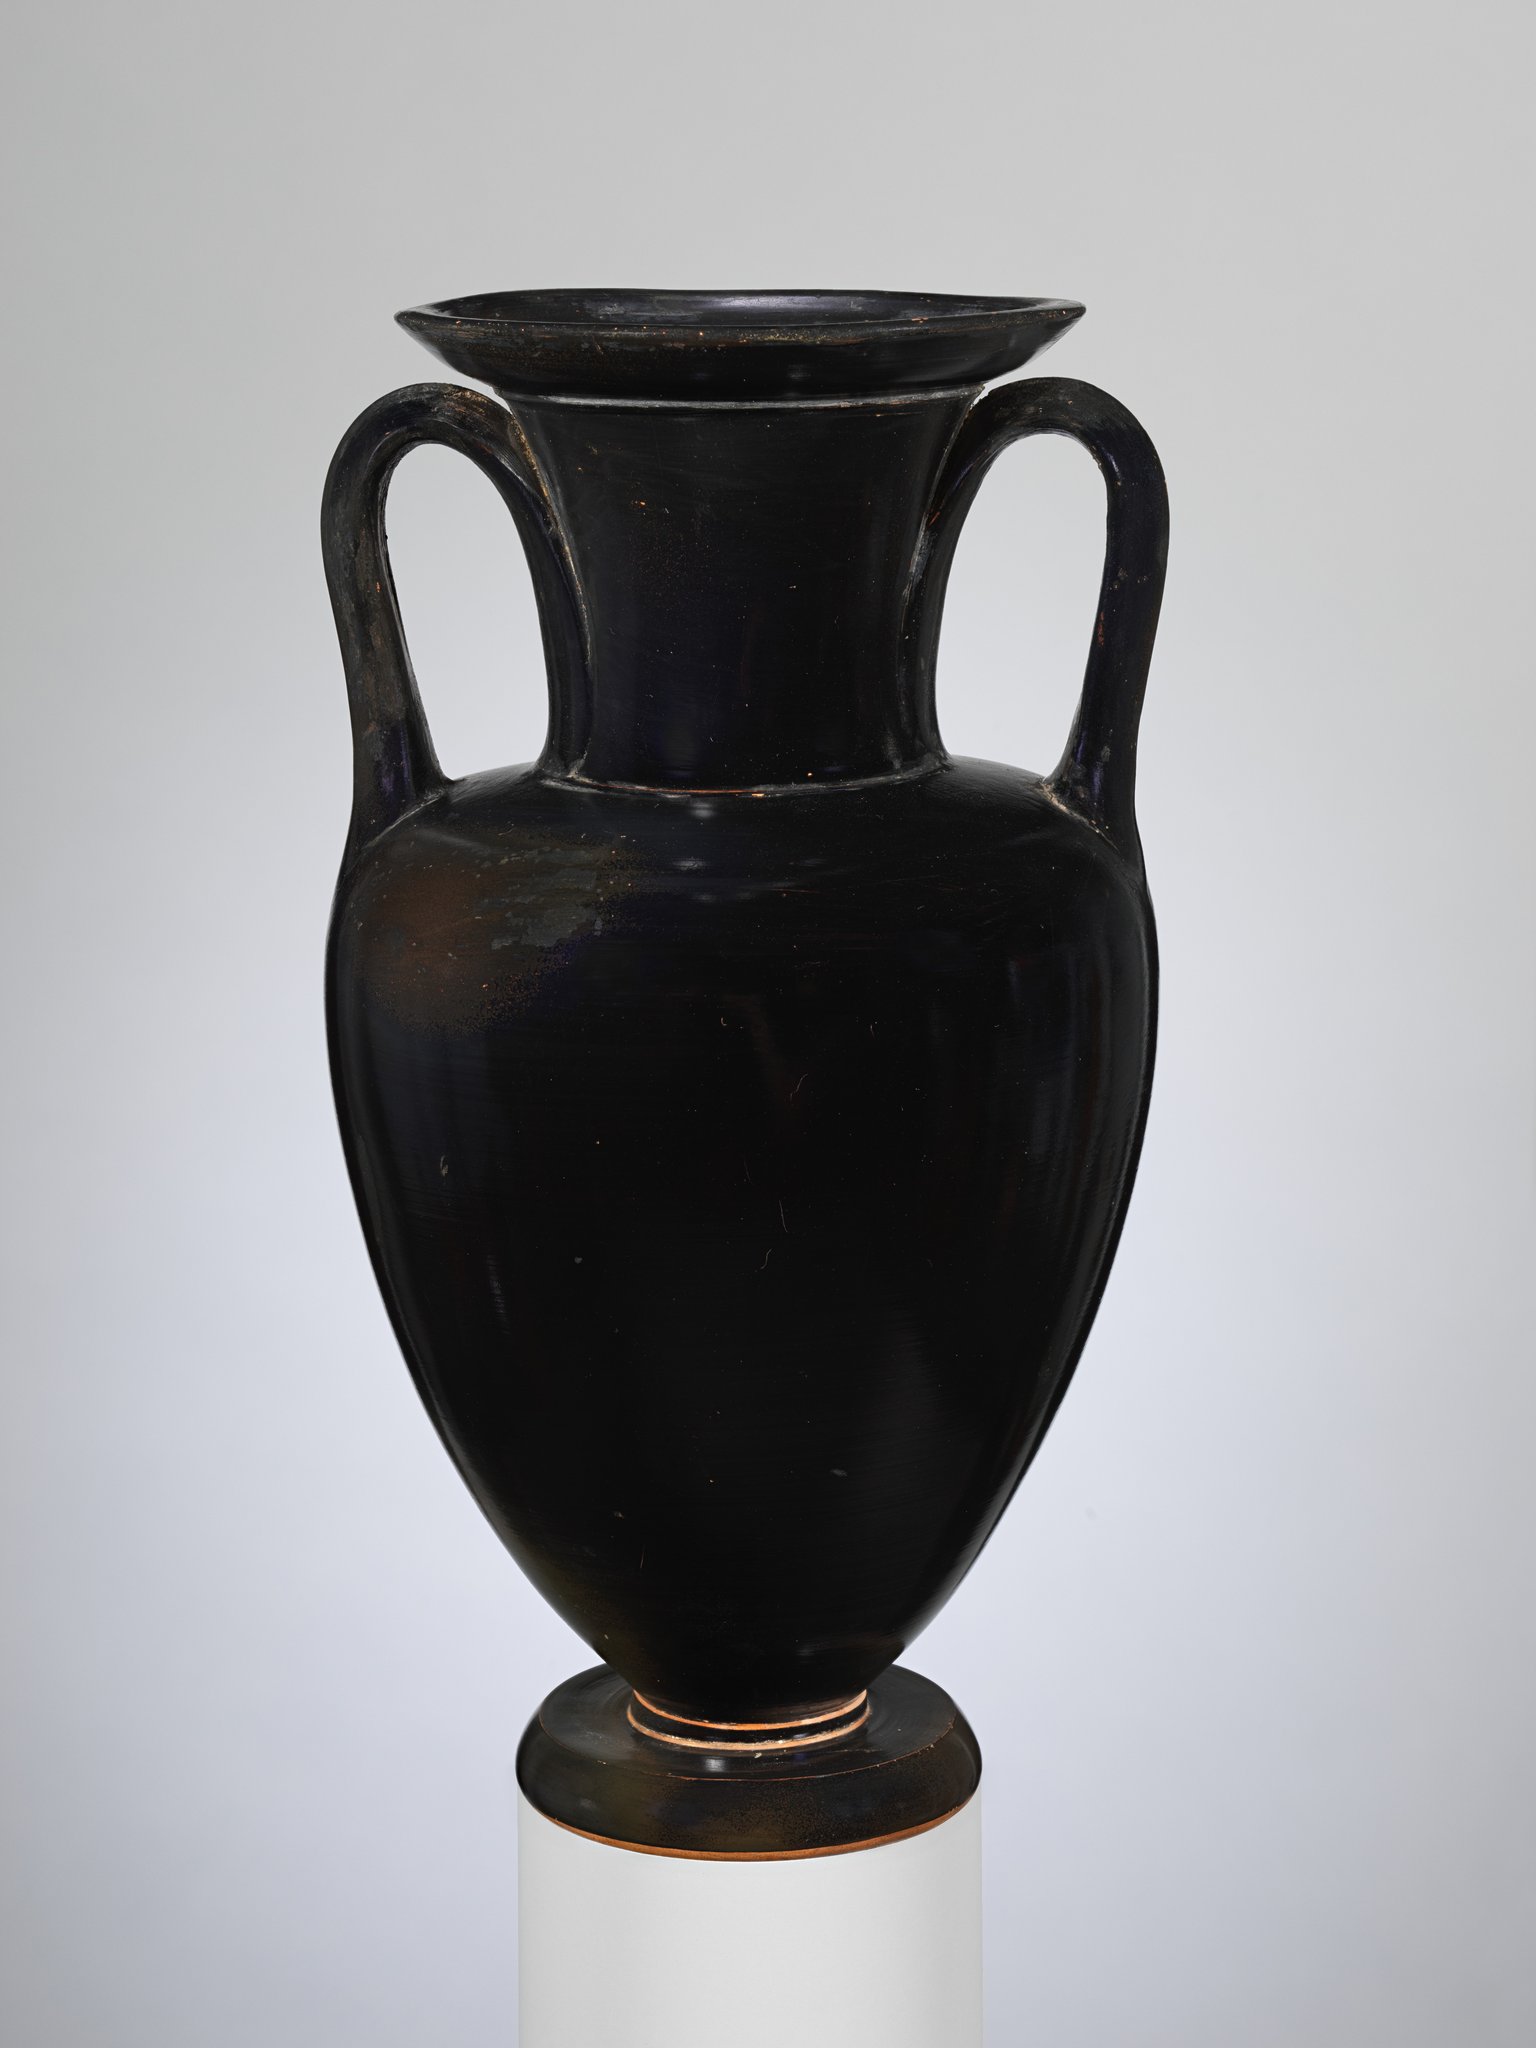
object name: nolan neck amphora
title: Terracotta Nolan neck-amphora (jar)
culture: greek, attic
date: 500-451 BCE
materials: terracotta